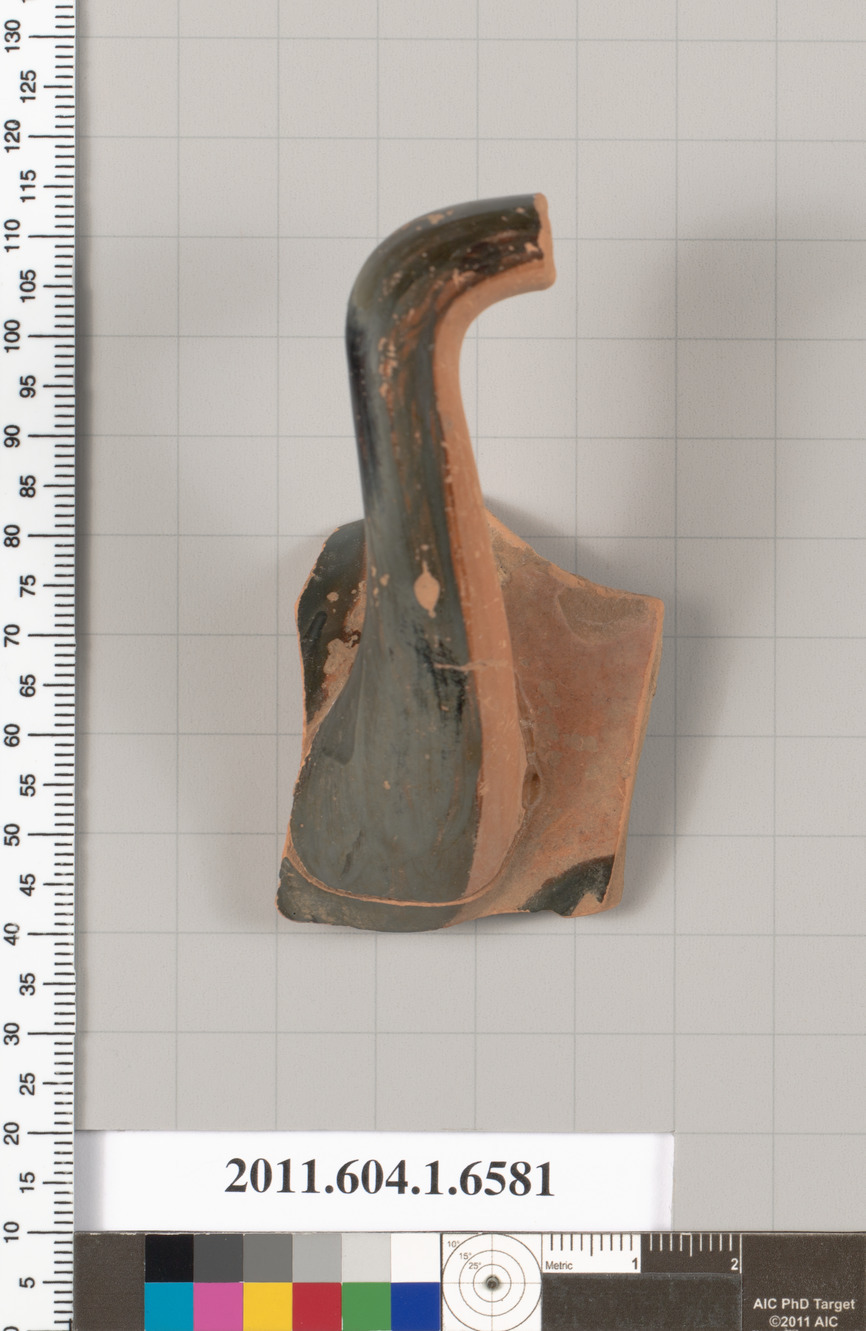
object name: kylix fragment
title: Terracotta fragment of a kylix (drinking cup)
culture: greek, attic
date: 490-480 BCE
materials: terracotta